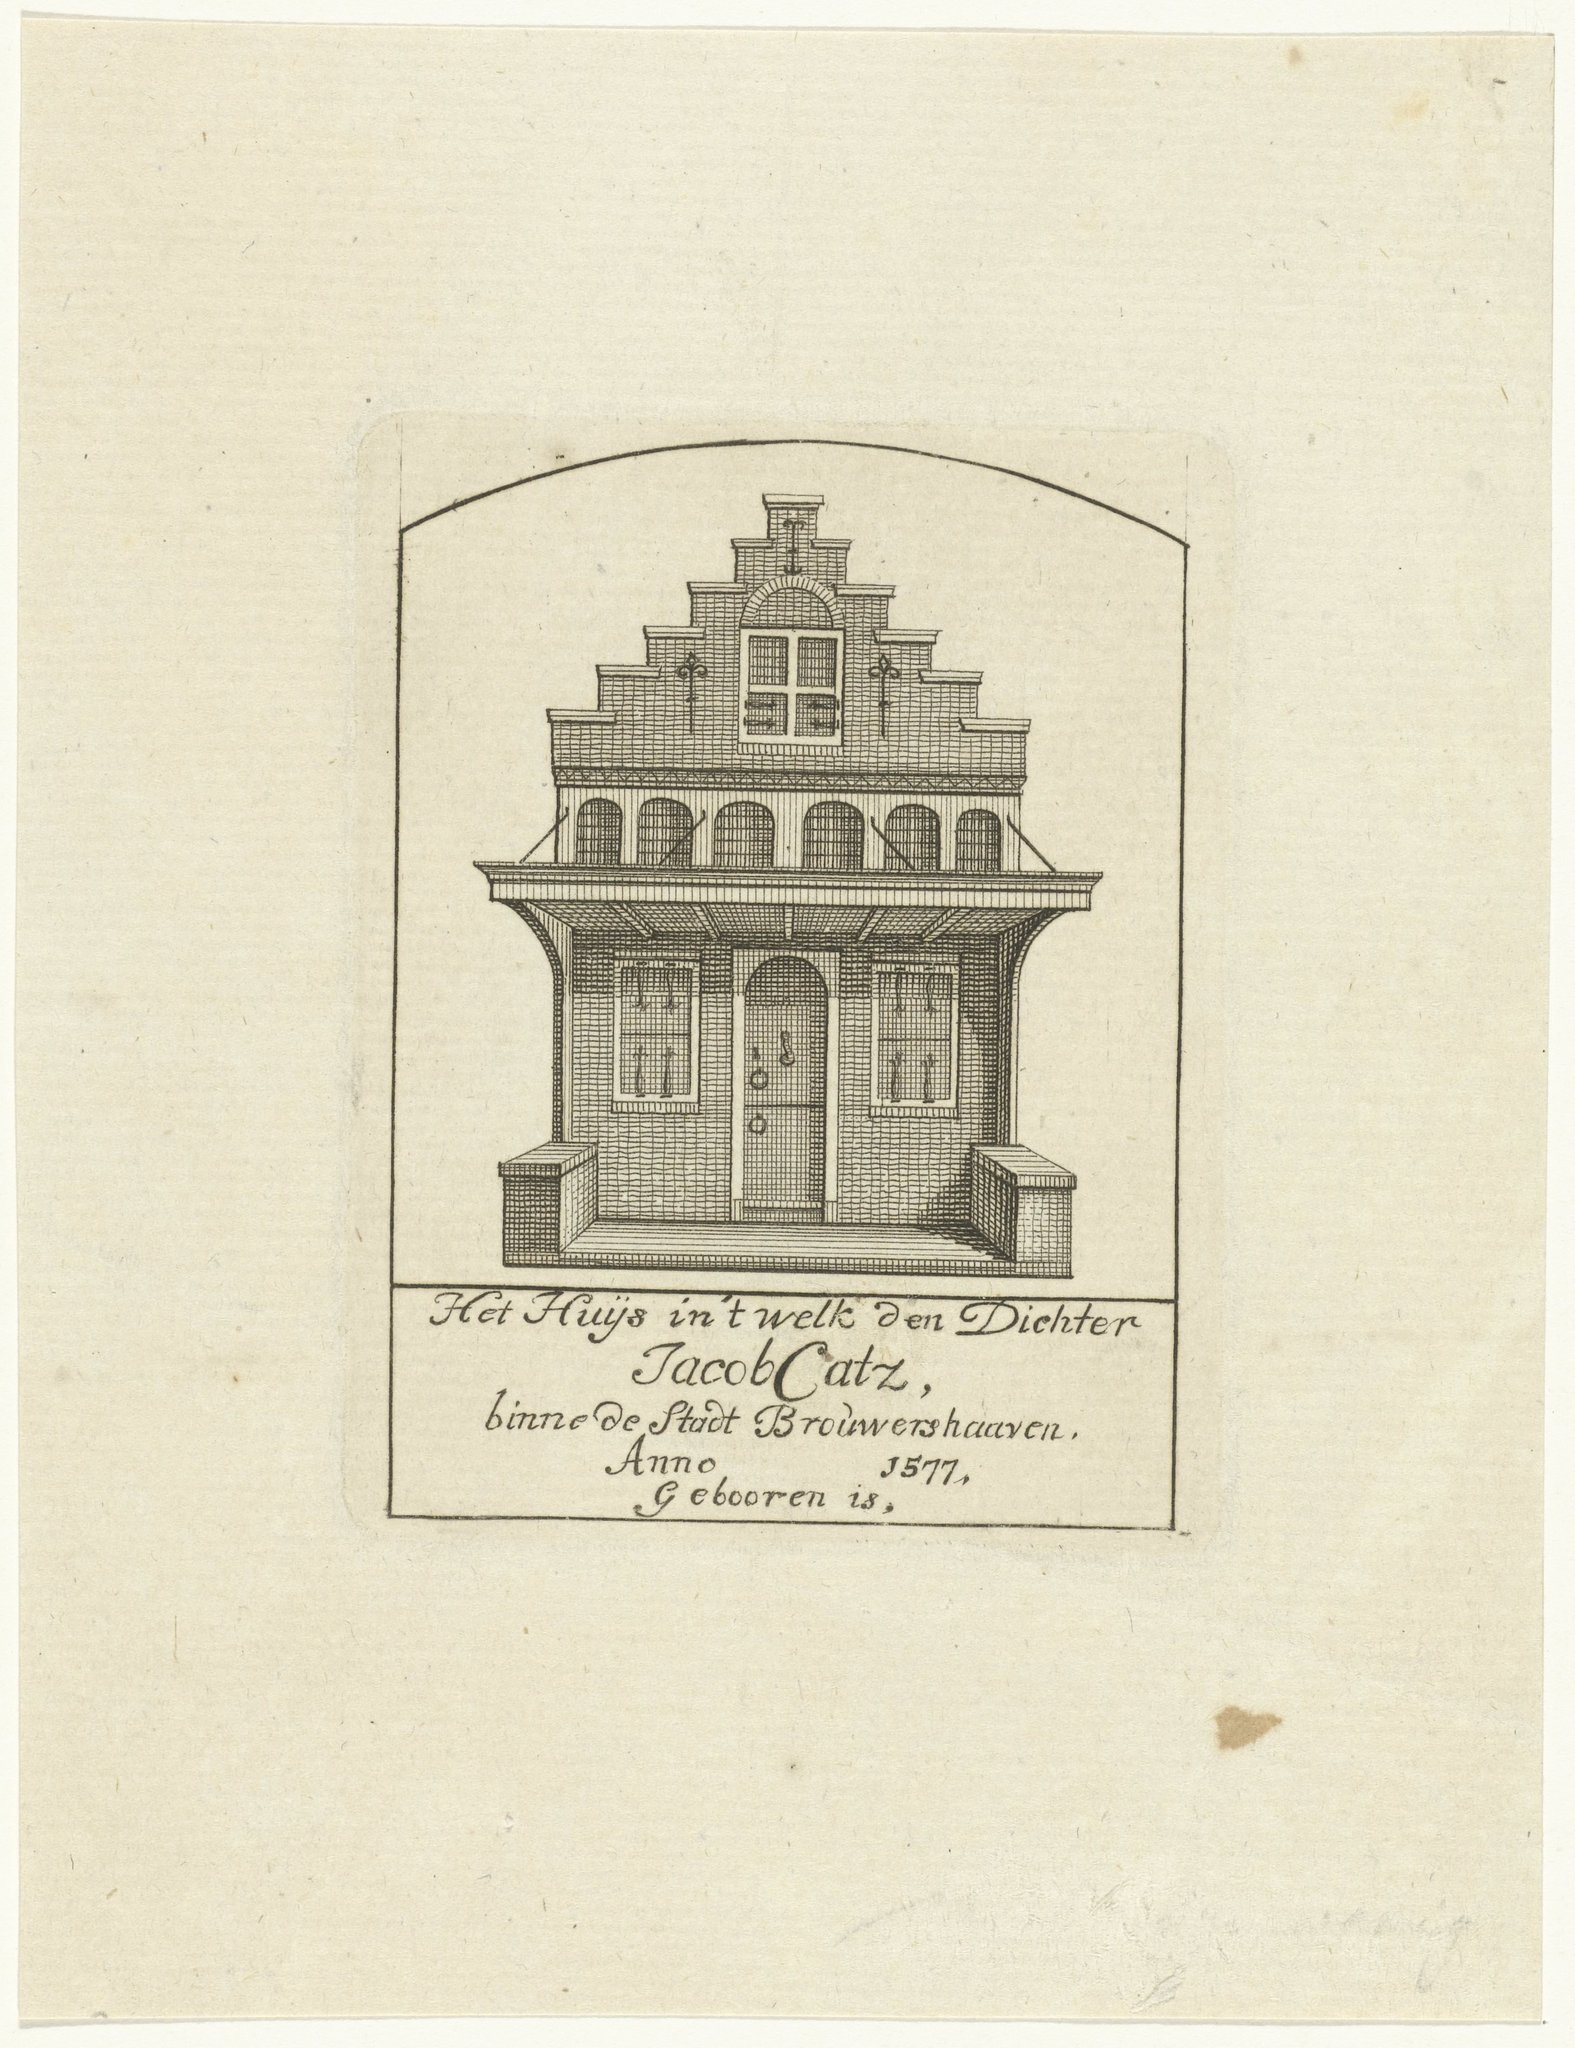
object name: print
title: Huis met trapgevel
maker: jan caspar philips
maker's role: draughtsman, print maker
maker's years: 1700-1775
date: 1736-1775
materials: paper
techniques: etching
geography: amsterdam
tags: the hague, jacob cats (1577-1660), façade (of house or building)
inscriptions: collector's mark: Lugt 964